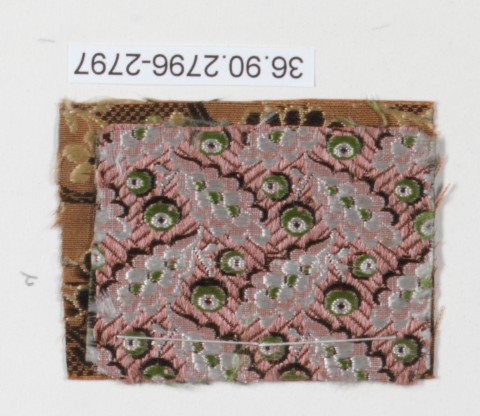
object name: piece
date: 1801-1900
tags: flowers